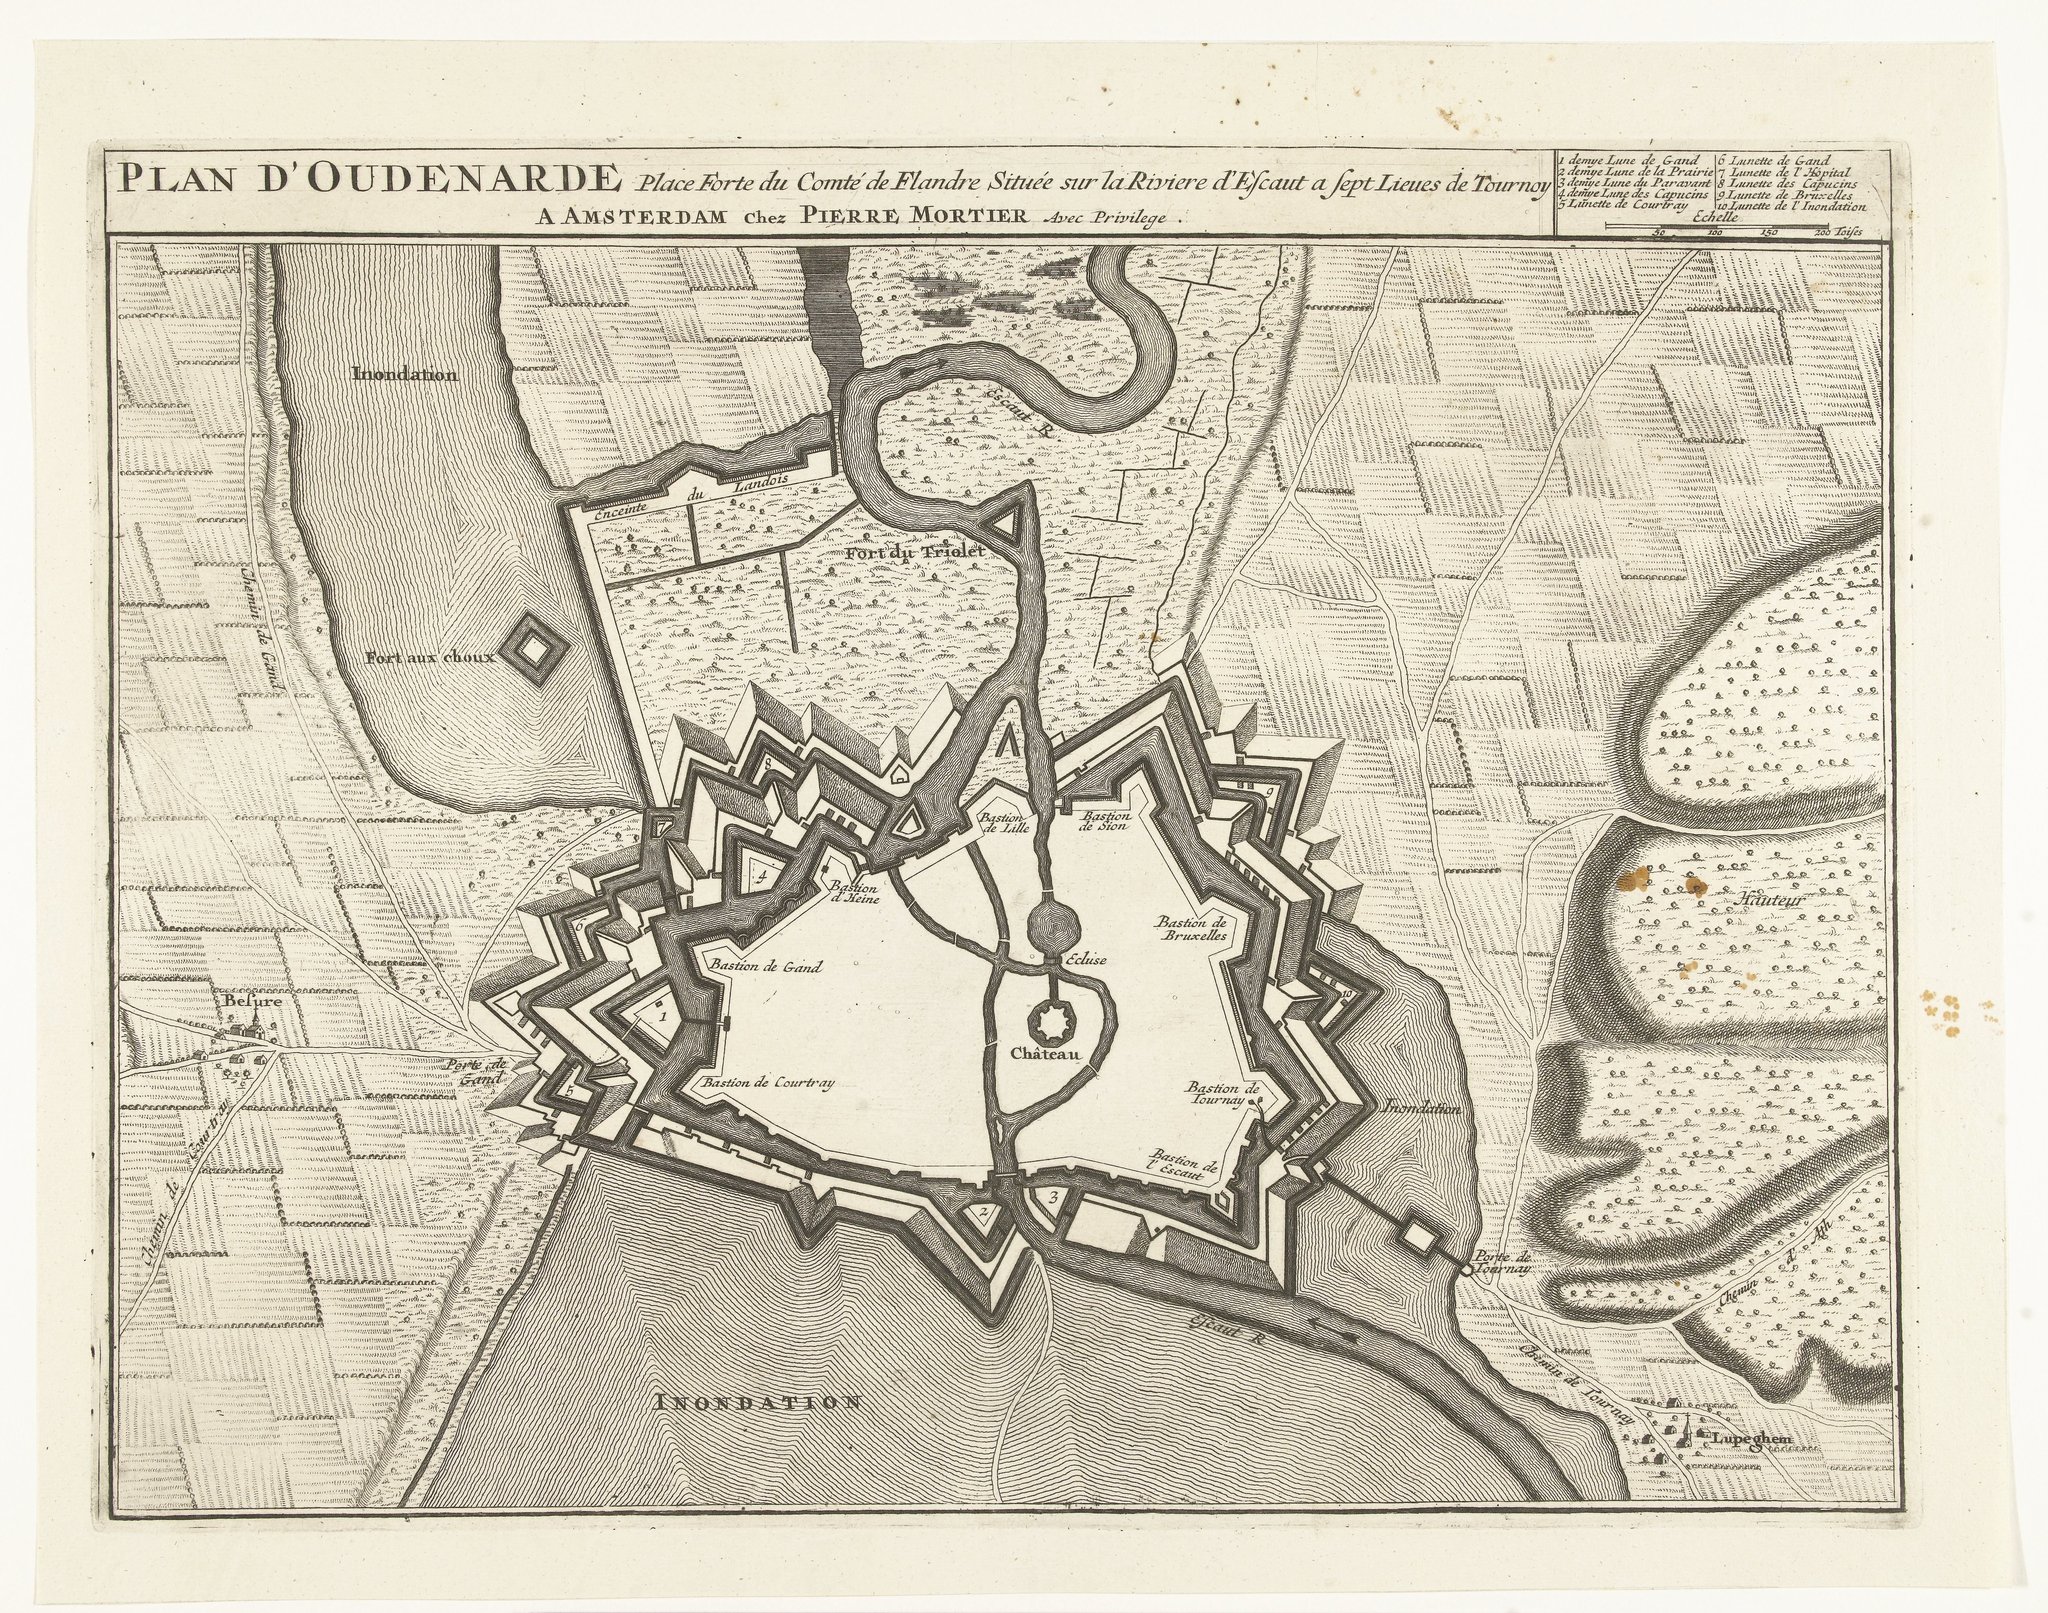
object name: print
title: Plattegrond van Oudenaarde, ca. 1708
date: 1708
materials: paper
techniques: etching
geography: amsterdam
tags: maps of cities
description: Plattegrond van de versterkingen rond de stad Oudenaarde, ca. 1708.